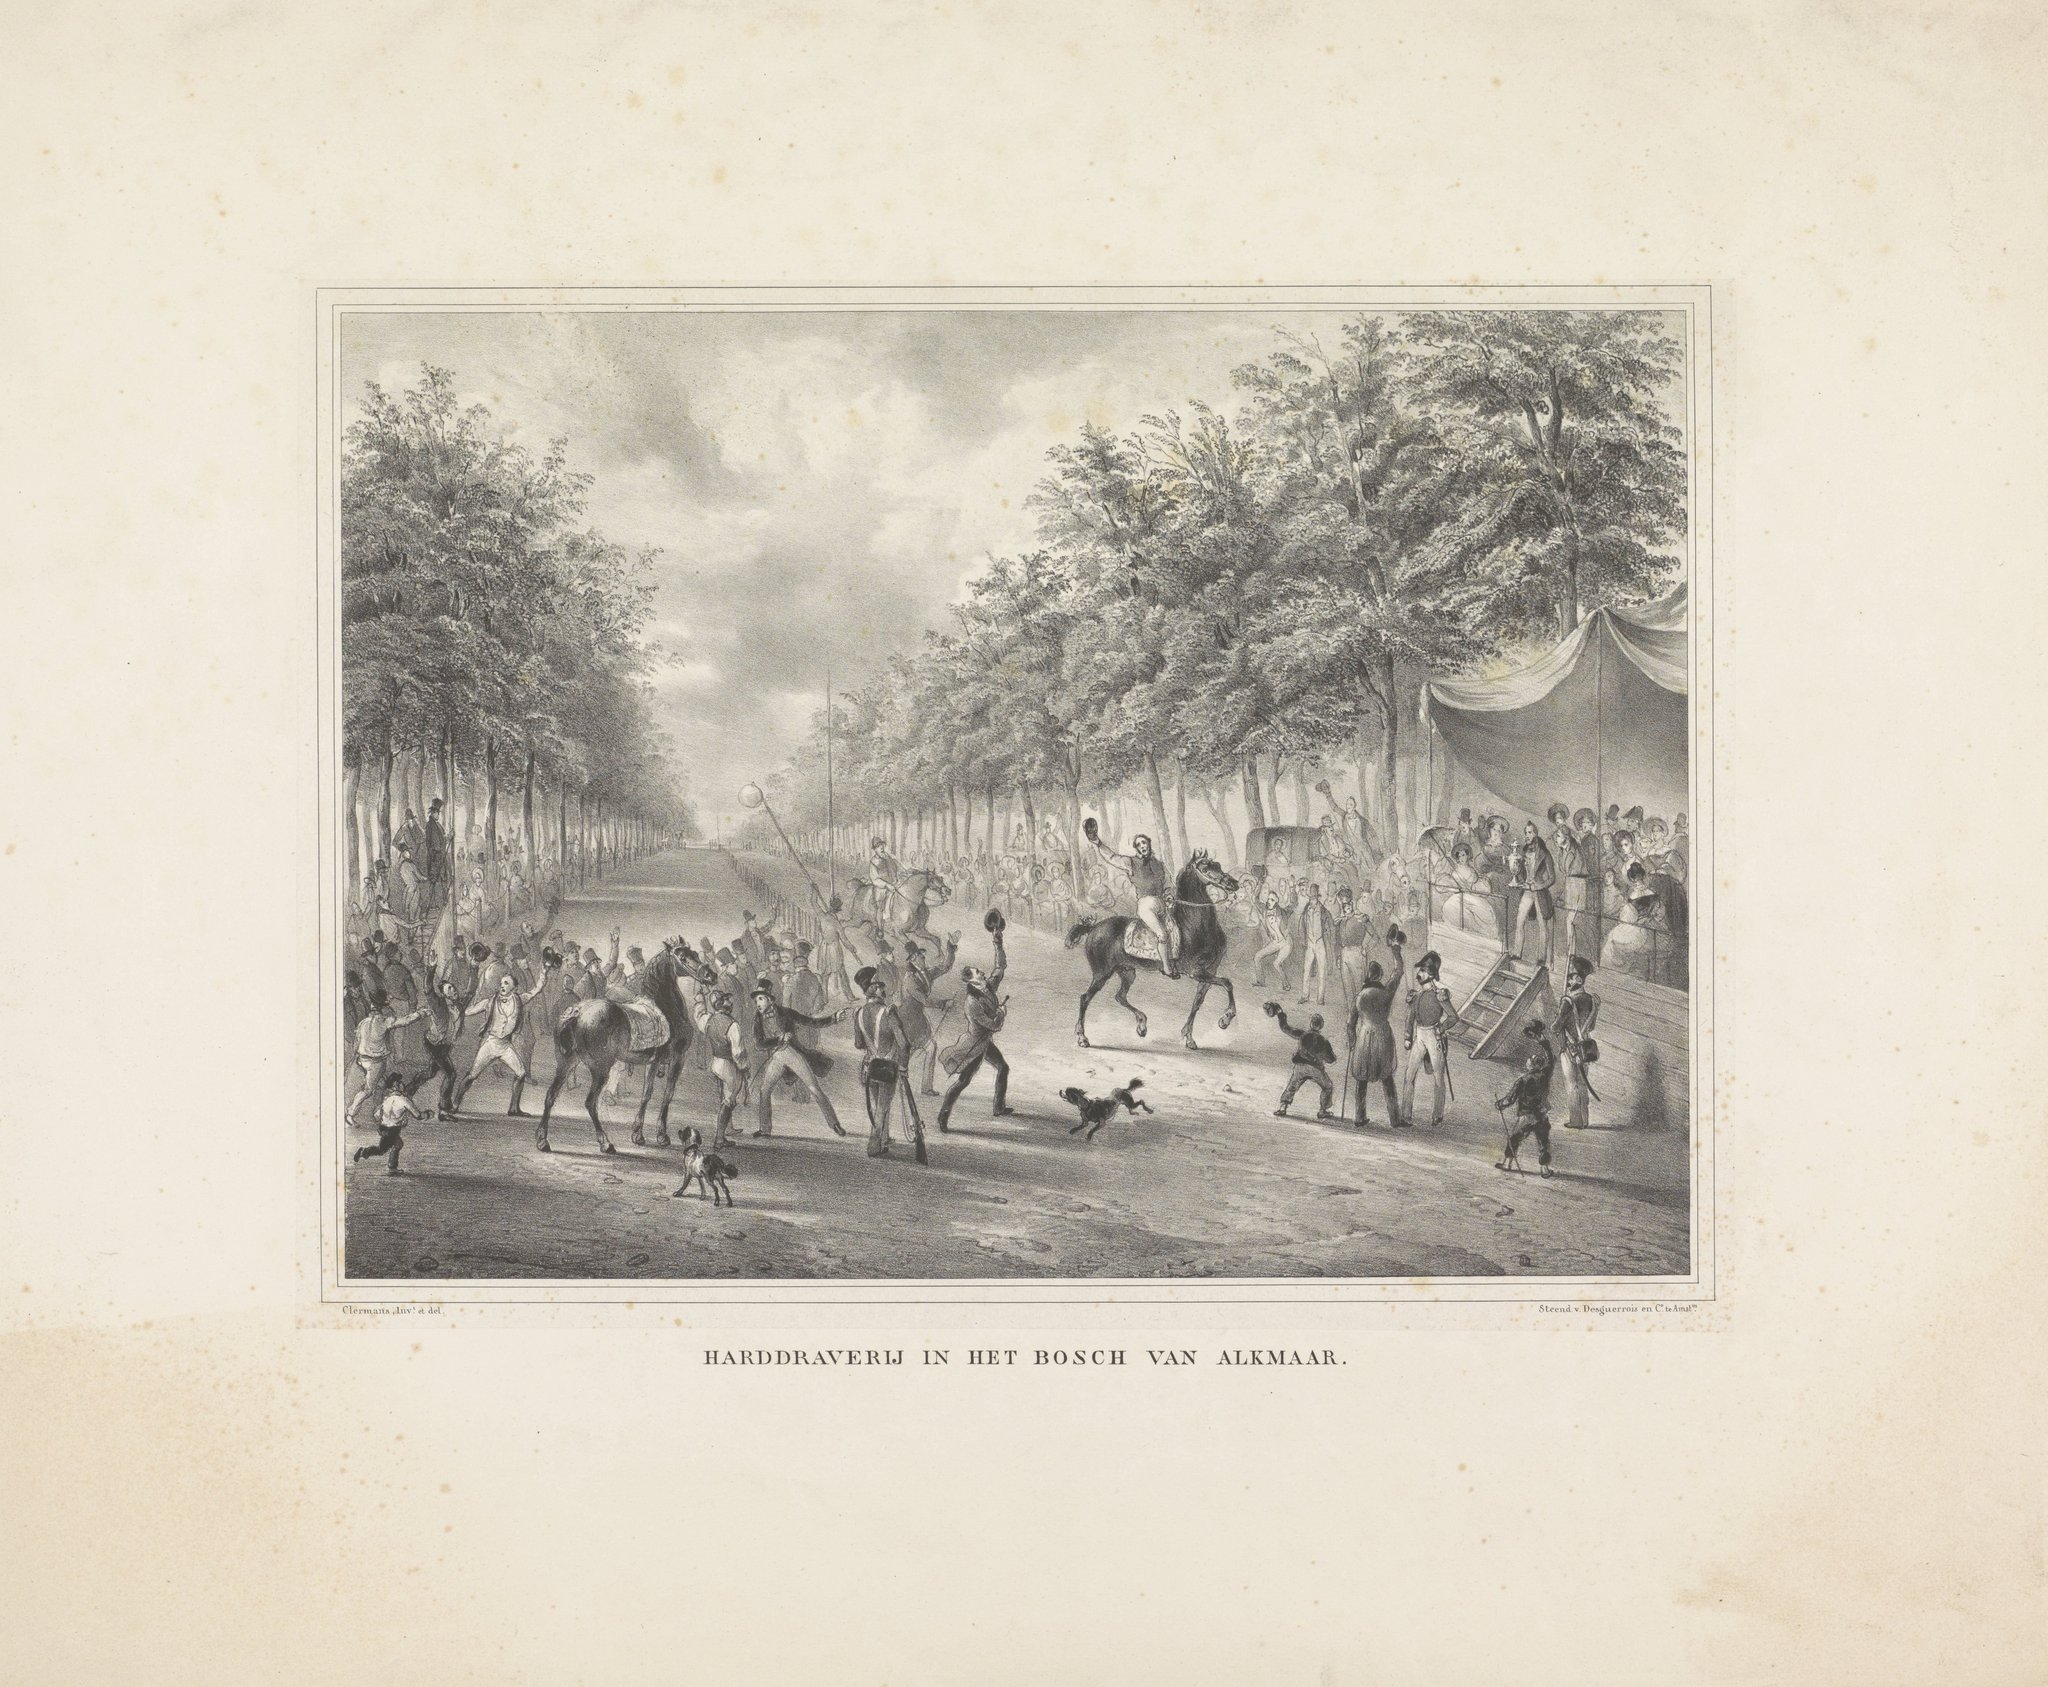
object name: cartoon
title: Harddraverij in de Hout van Alkmaar, 1825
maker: j.b. clermans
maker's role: print maker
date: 1825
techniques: printmaking, lithograph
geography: amsterdam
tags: horse-racing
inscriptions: collector's mark: Lugt 2228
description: Paardenrace gehouden in de renbaan in de Hout te Alkmaar op 10 september 1825. Langs de baan staan toeschouwers, vooraan zwaait de winnaar van de wedstrijd naar het publiek. Rechts op de tribune staat een man klaar om de beker aan de winnaar uit te reiken,